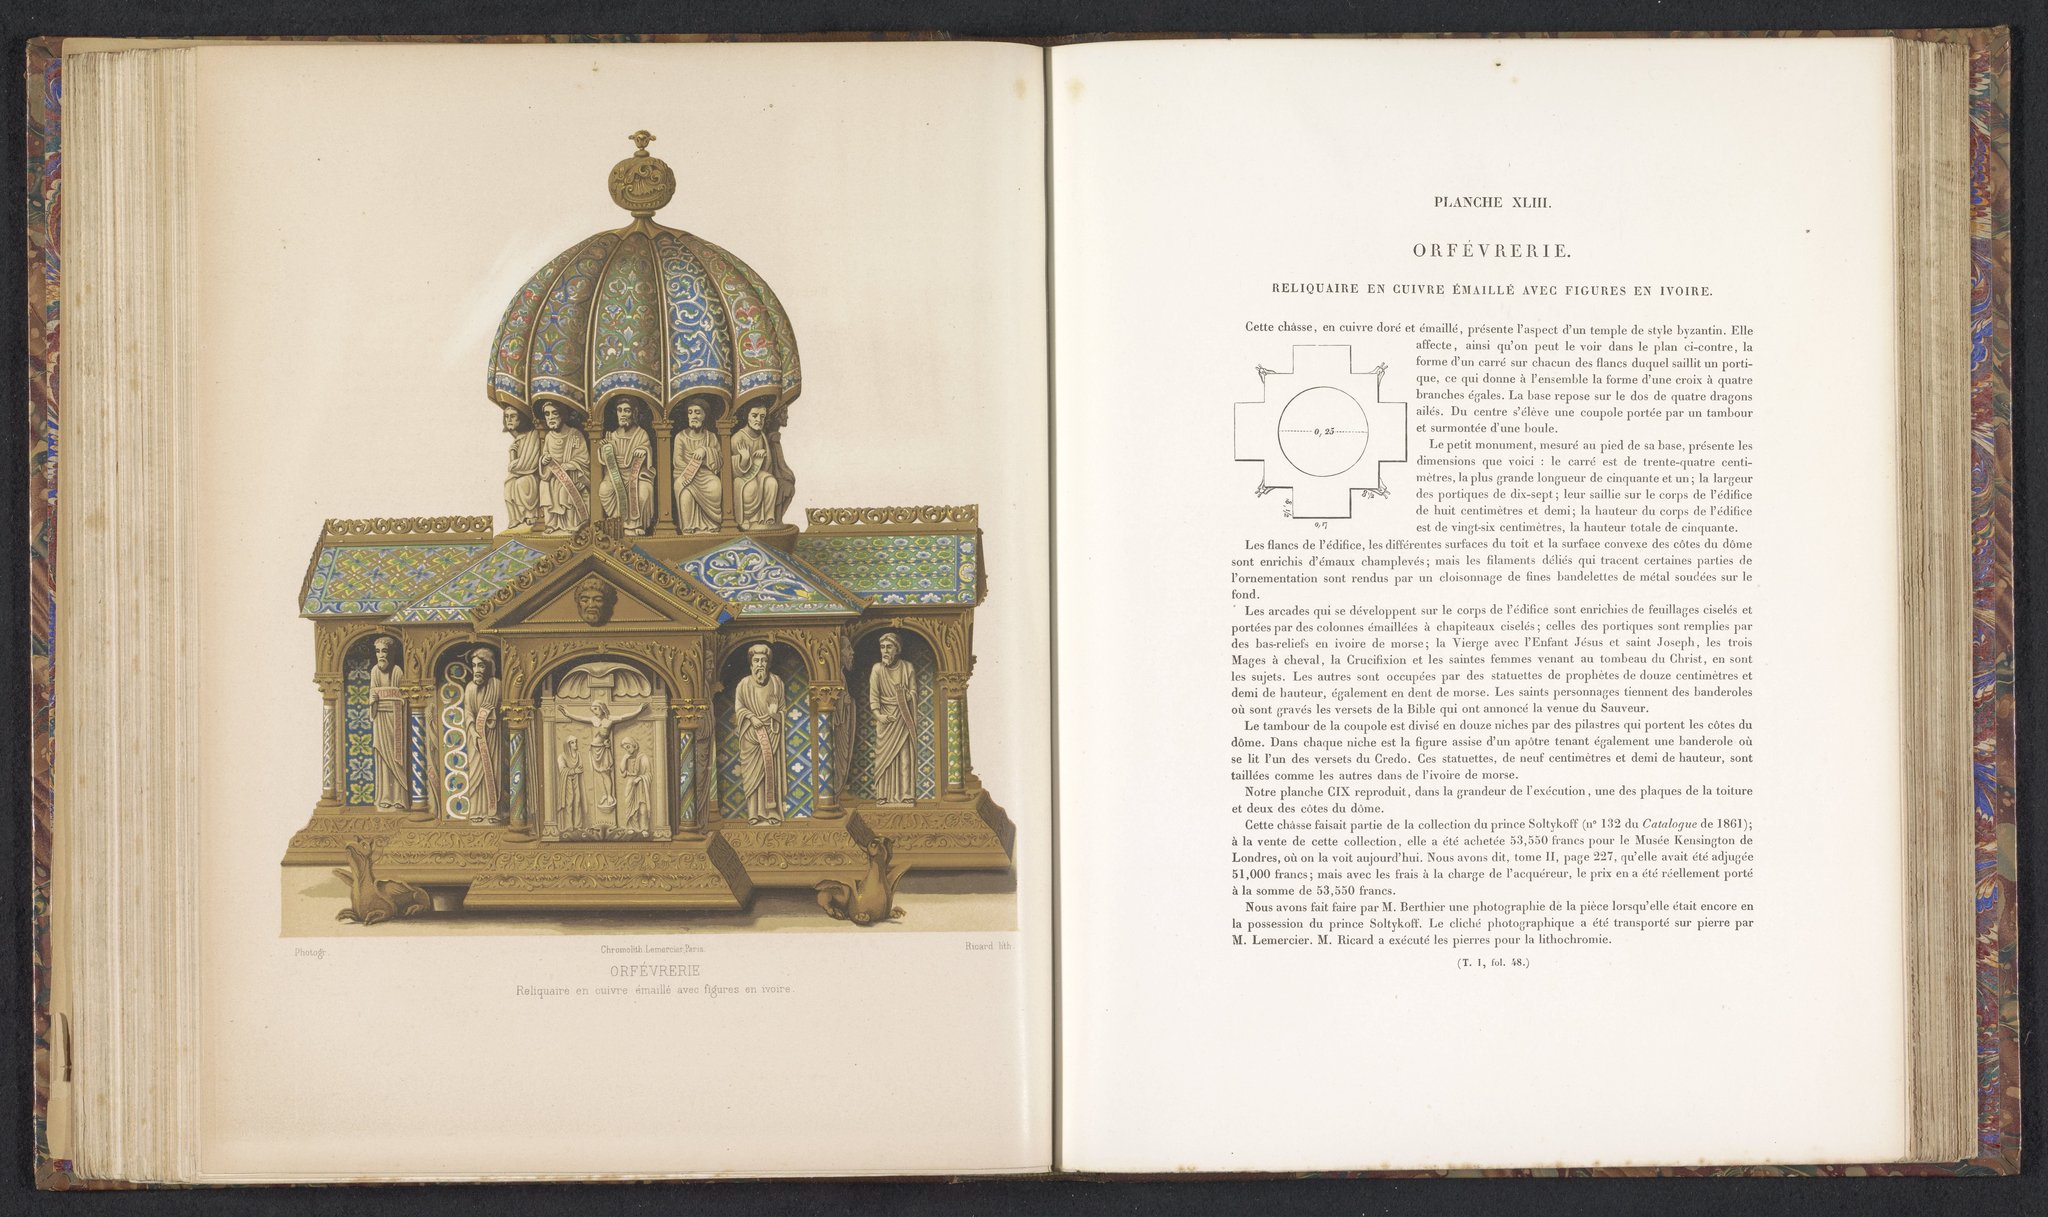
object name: print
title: Orfévrerie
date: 1859-1864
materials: paper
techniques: chromolithography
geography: paris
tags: relics (and reliquaries)